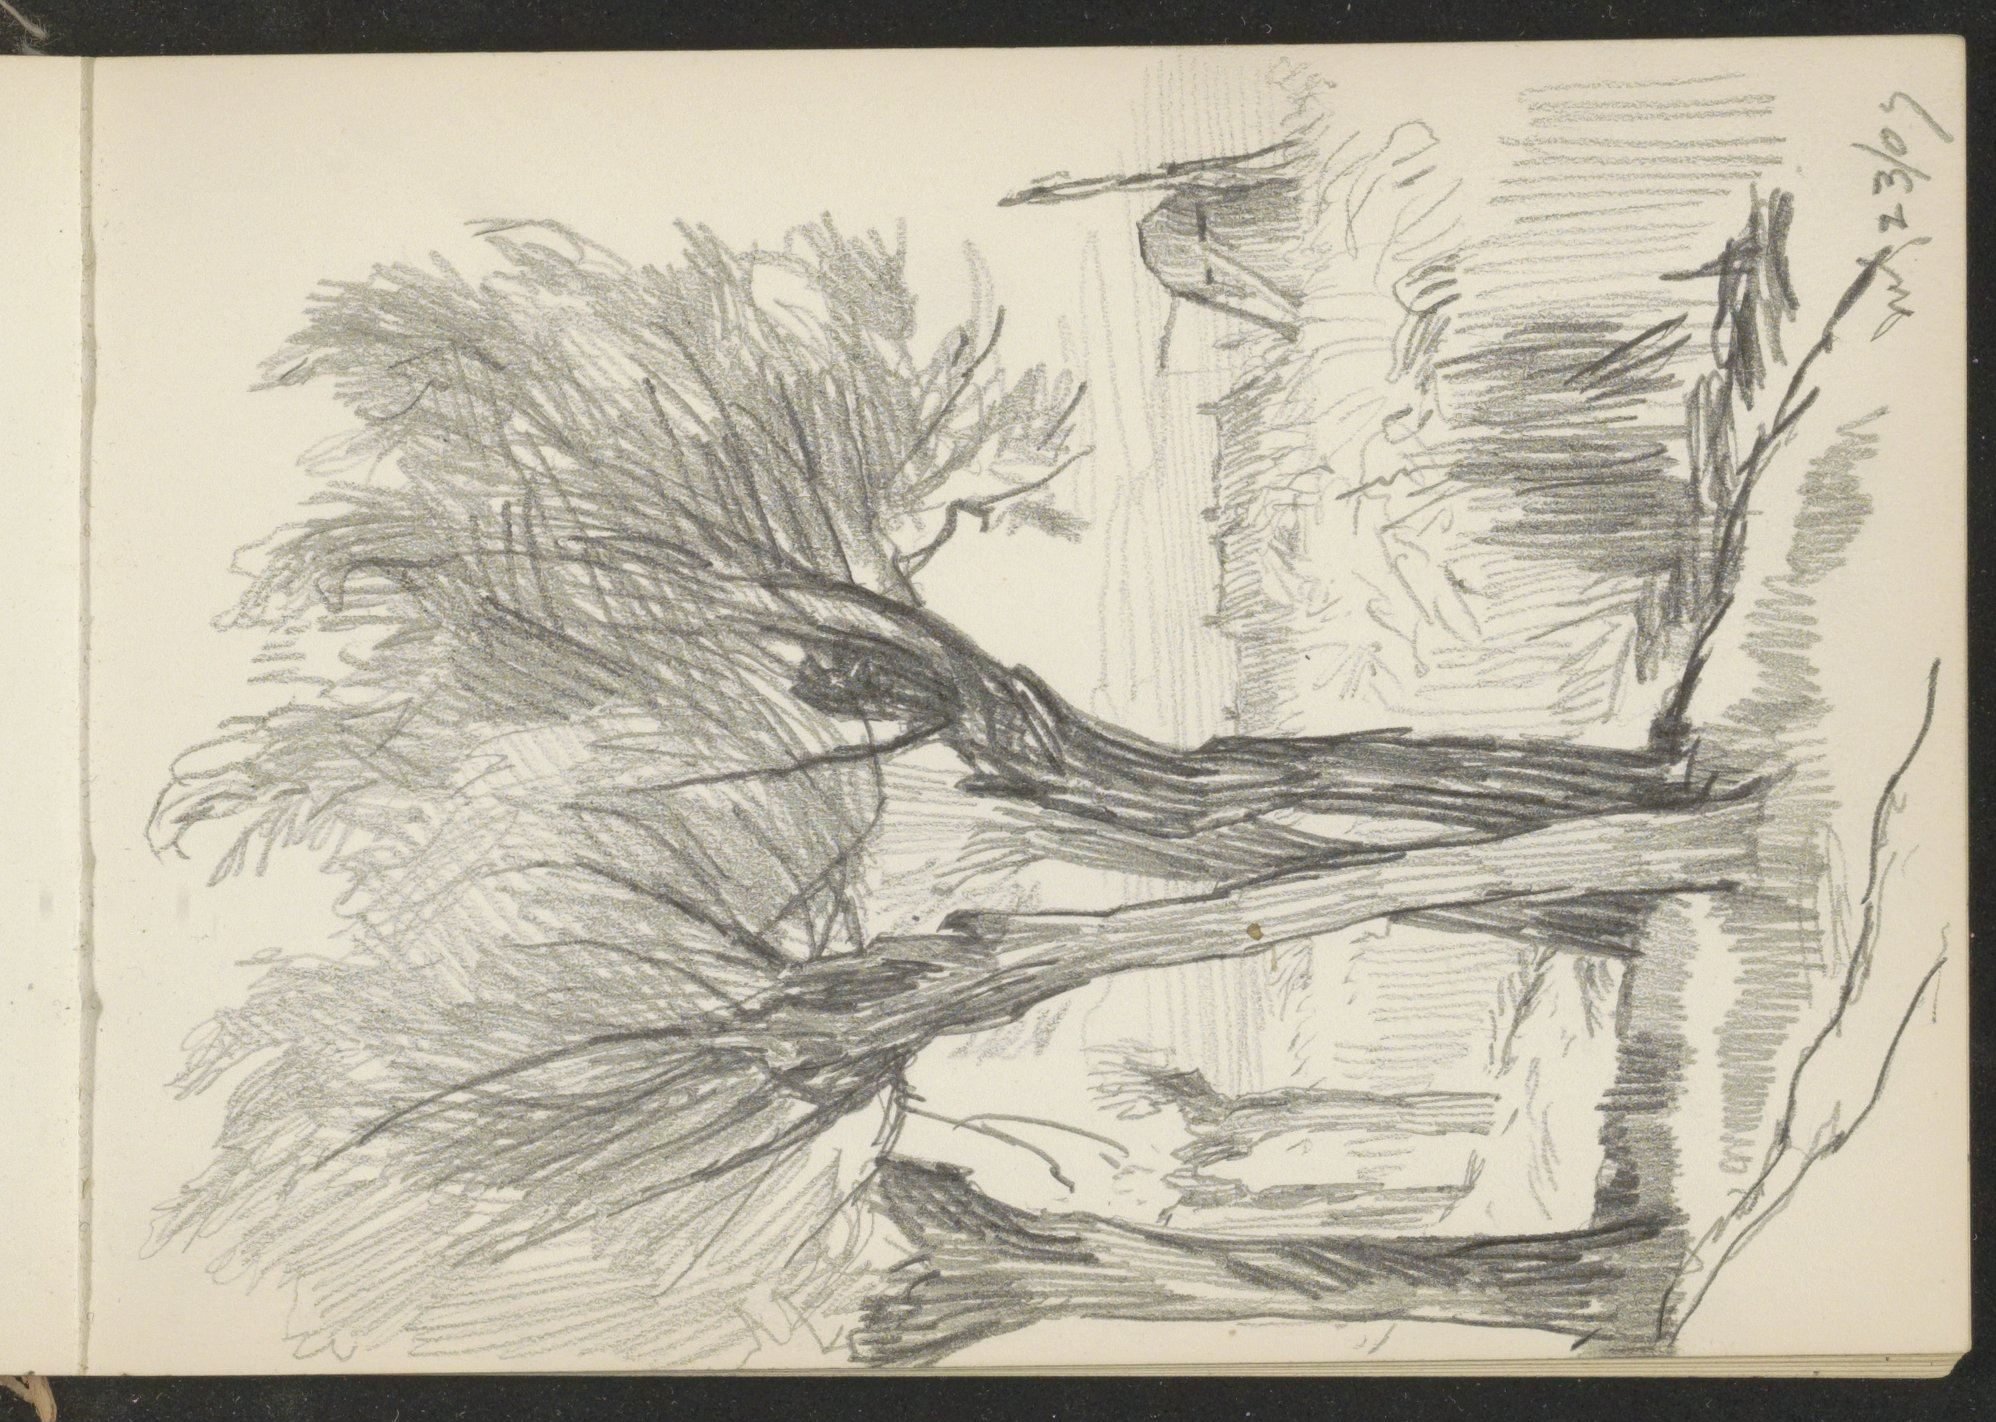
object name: sketchbook leaf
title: Wilgen langs een sloot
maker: alexander shilling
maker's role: draughtsman, print maker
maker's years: 1859-1937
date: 1907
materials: paper, pencil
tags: trees, windmill in landscape, small canal, ditch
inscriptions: date: ‘Jul 23/07’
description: Op de achtergrond een molen en de daken van huizen. Blad 14 recto uit een schetsboek met 24 bladen.